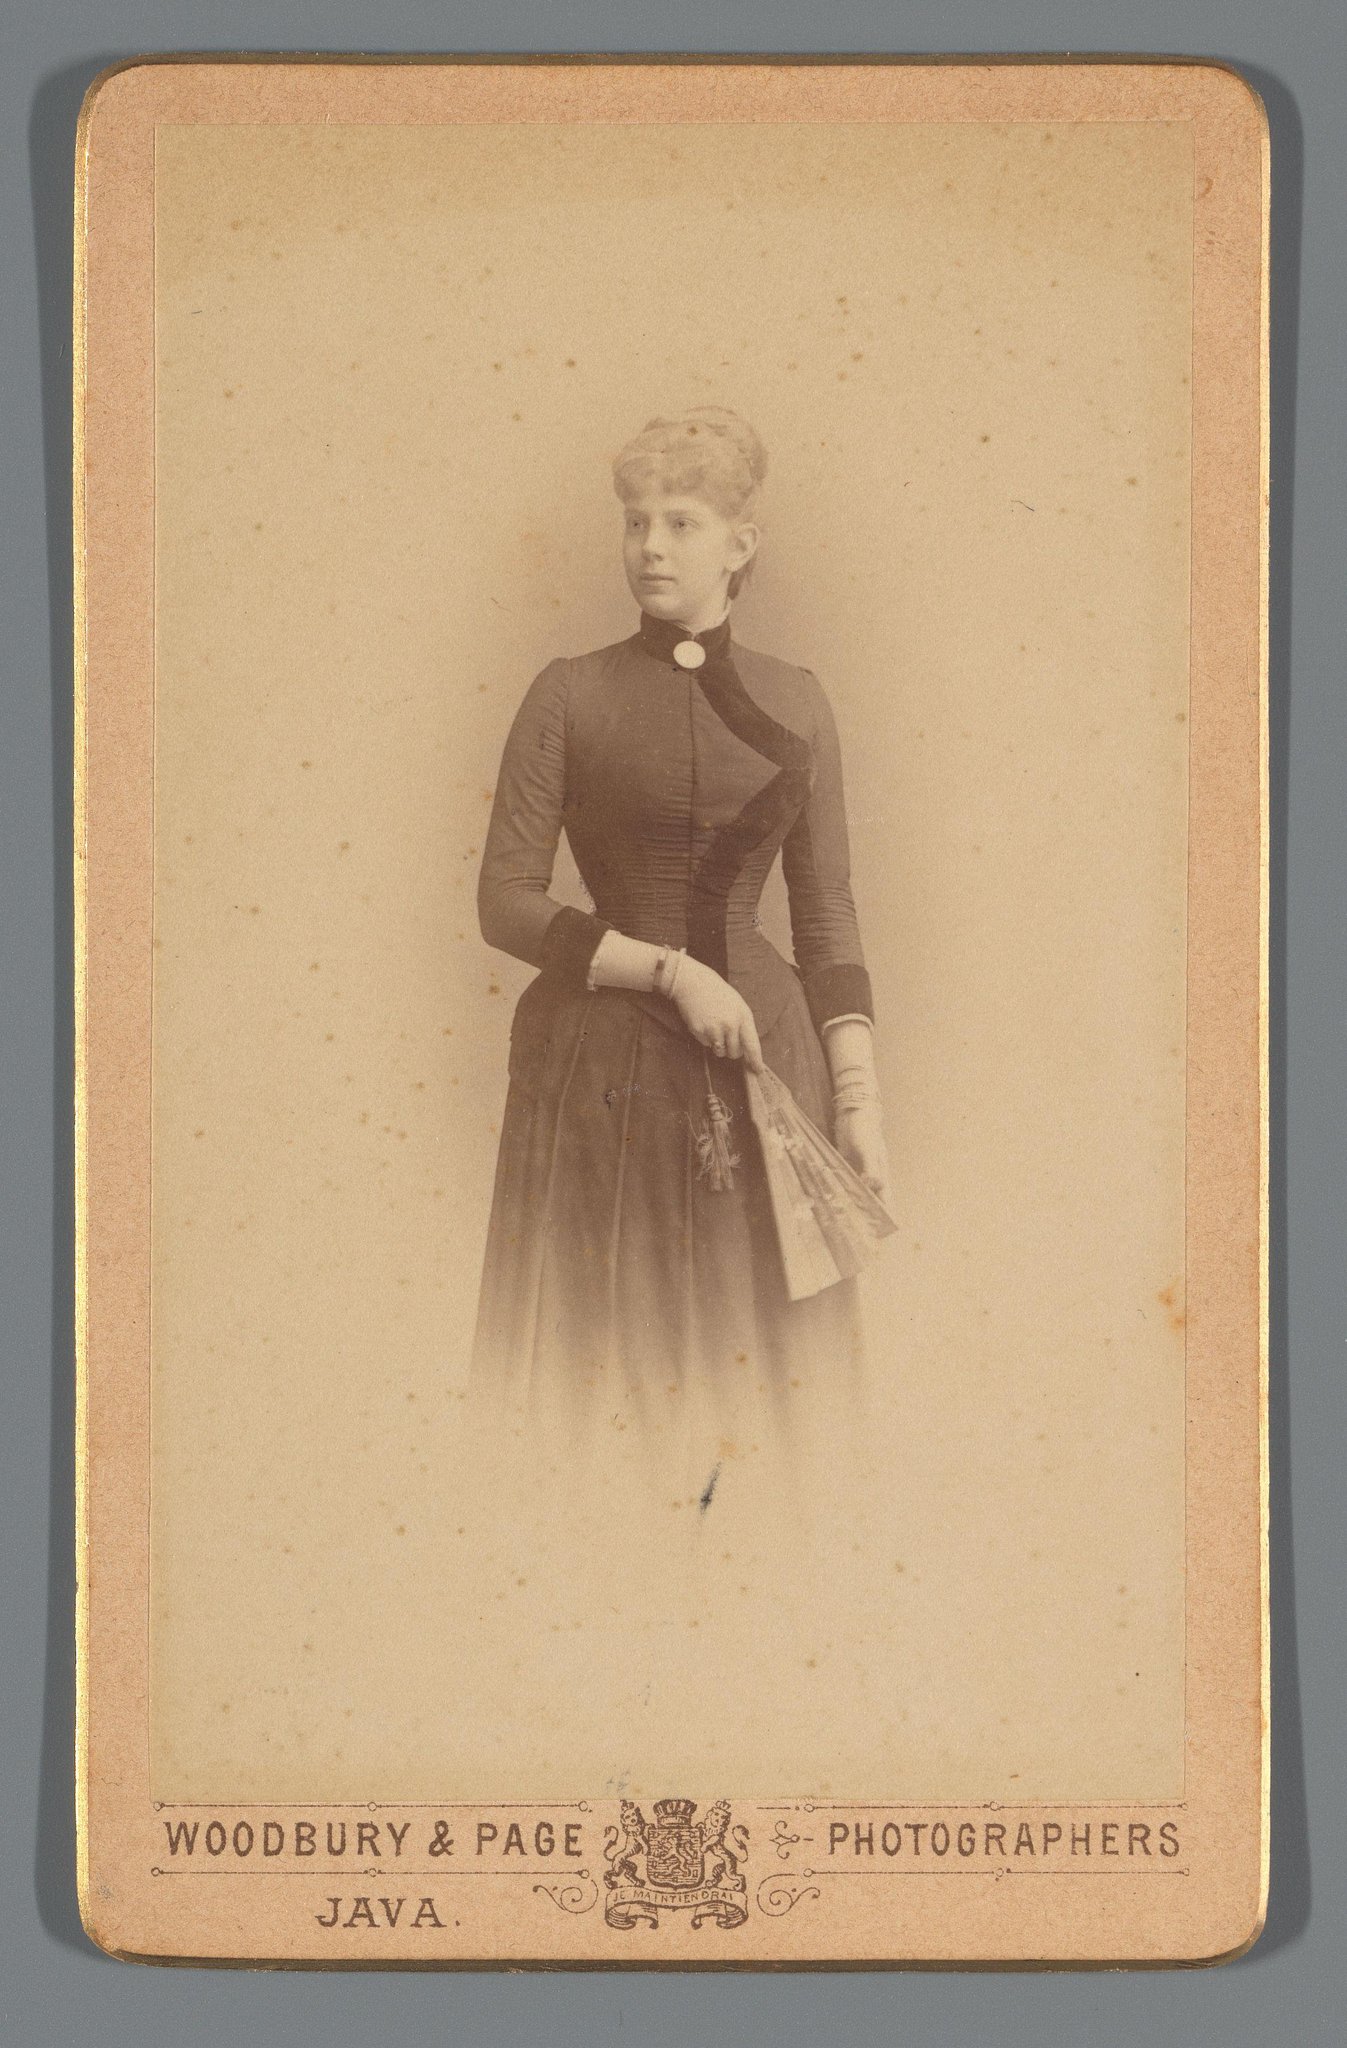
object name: carte de visite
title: Studioportret van Pauline van den Berg met een waaier in haar rechterhand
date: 1870-1900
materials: cardboard, photographic support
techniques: albumen print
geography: java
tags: pauline wilhelmine louise blommestein-van den berg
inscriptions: name: ‘WOODBURY & PAGE / PHOTOGRAPHERS / JAVA.’, inscription: ‘Pauline Blommestein- / van den Berg’, name: ‘WOODBURY & PAGE PHOTOGRAPHERS / JAVA’